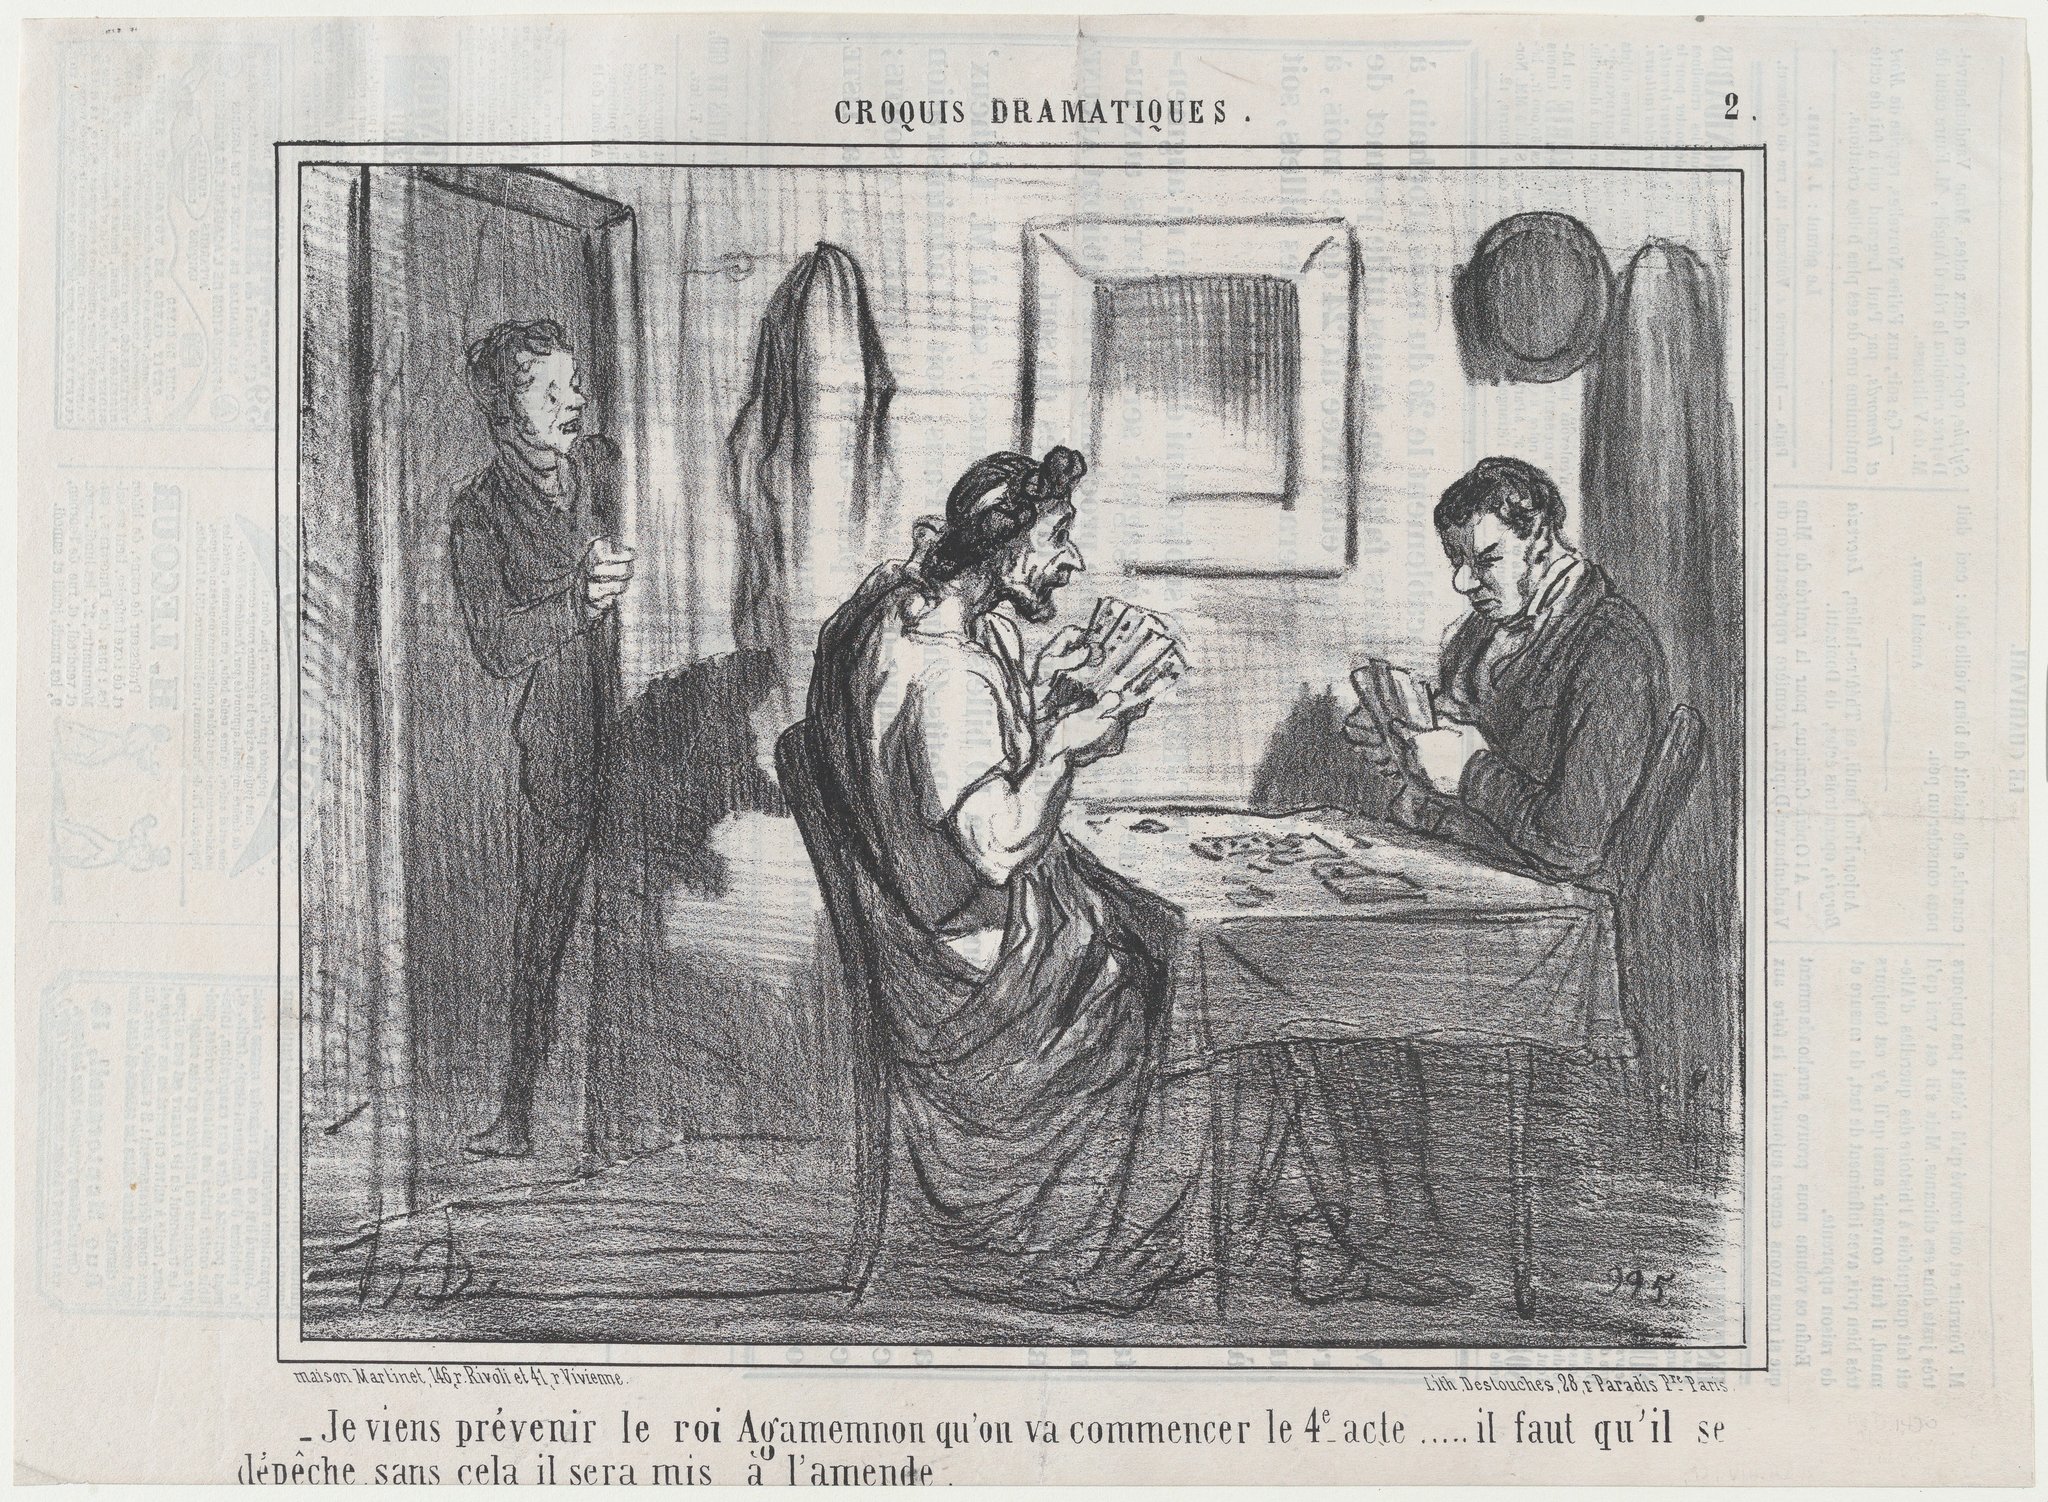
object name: print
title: Je viens prévenir le roi Agamemnon qu'on va commencer le 4e acte..., from Croquis Dramatiques, published in Le Charivari, November 27, 1856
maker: honoré daumier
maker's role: artist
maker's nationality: french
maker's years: 1808-1879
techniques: lithograph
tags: satire,men,playing cards